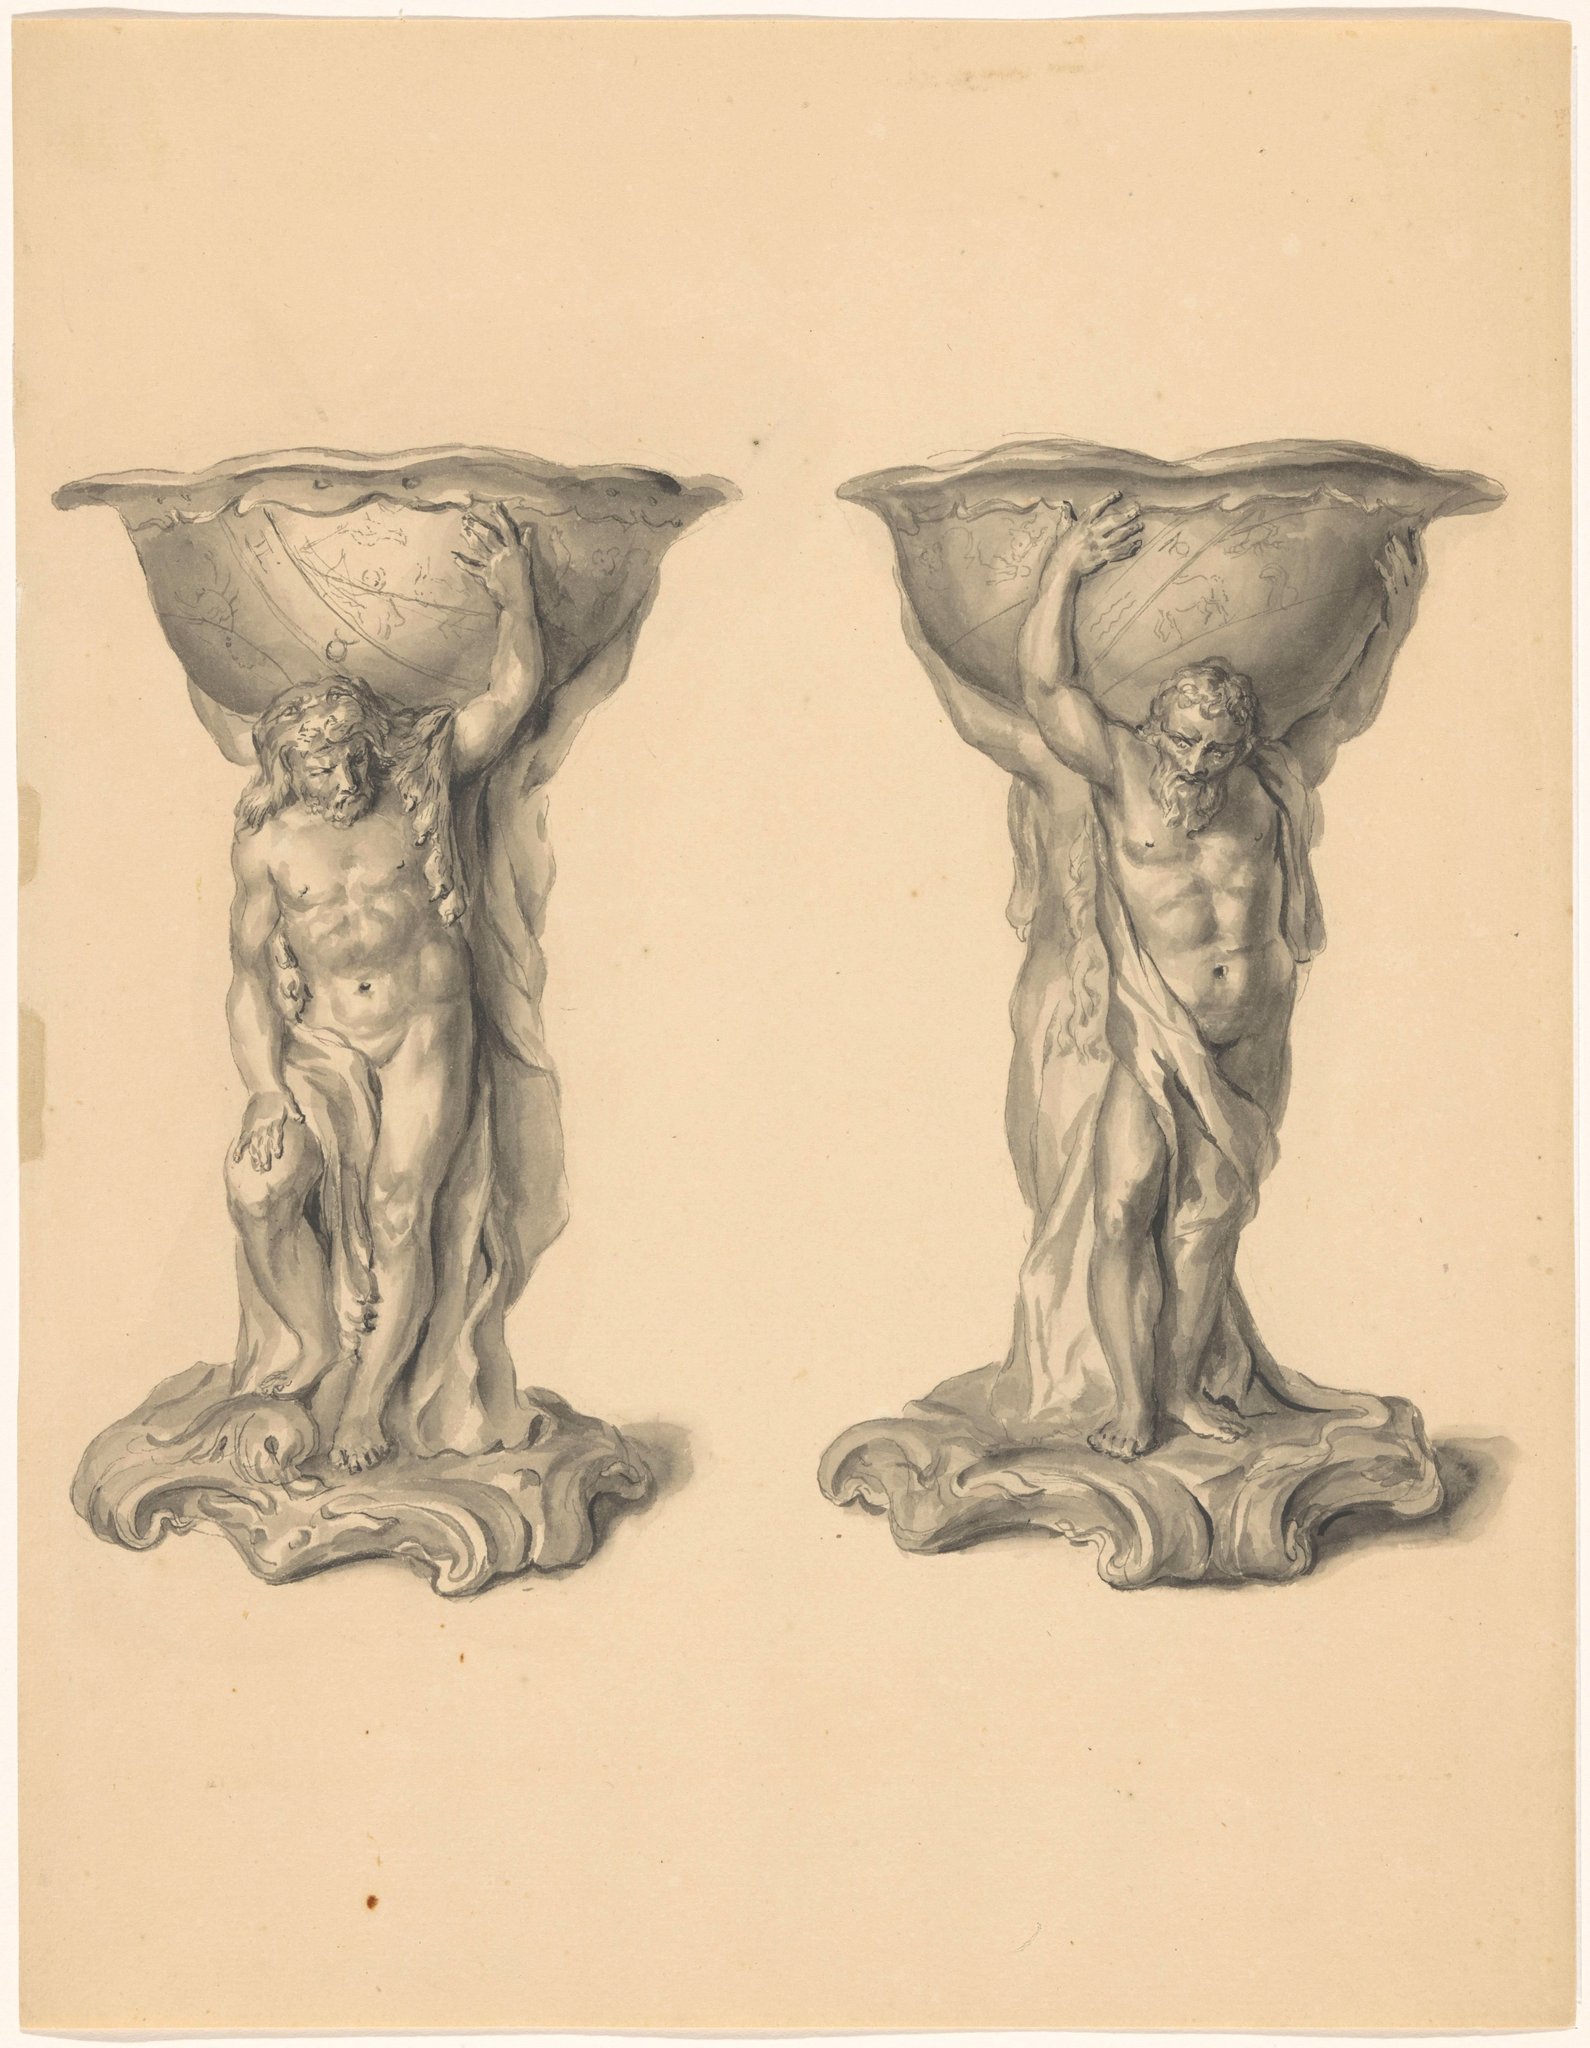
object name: album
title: Tekening van 17e eeuws zilver behorende bij een album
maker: Anonymous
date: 1725-1728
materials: paper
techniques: drawing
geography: amsterdam